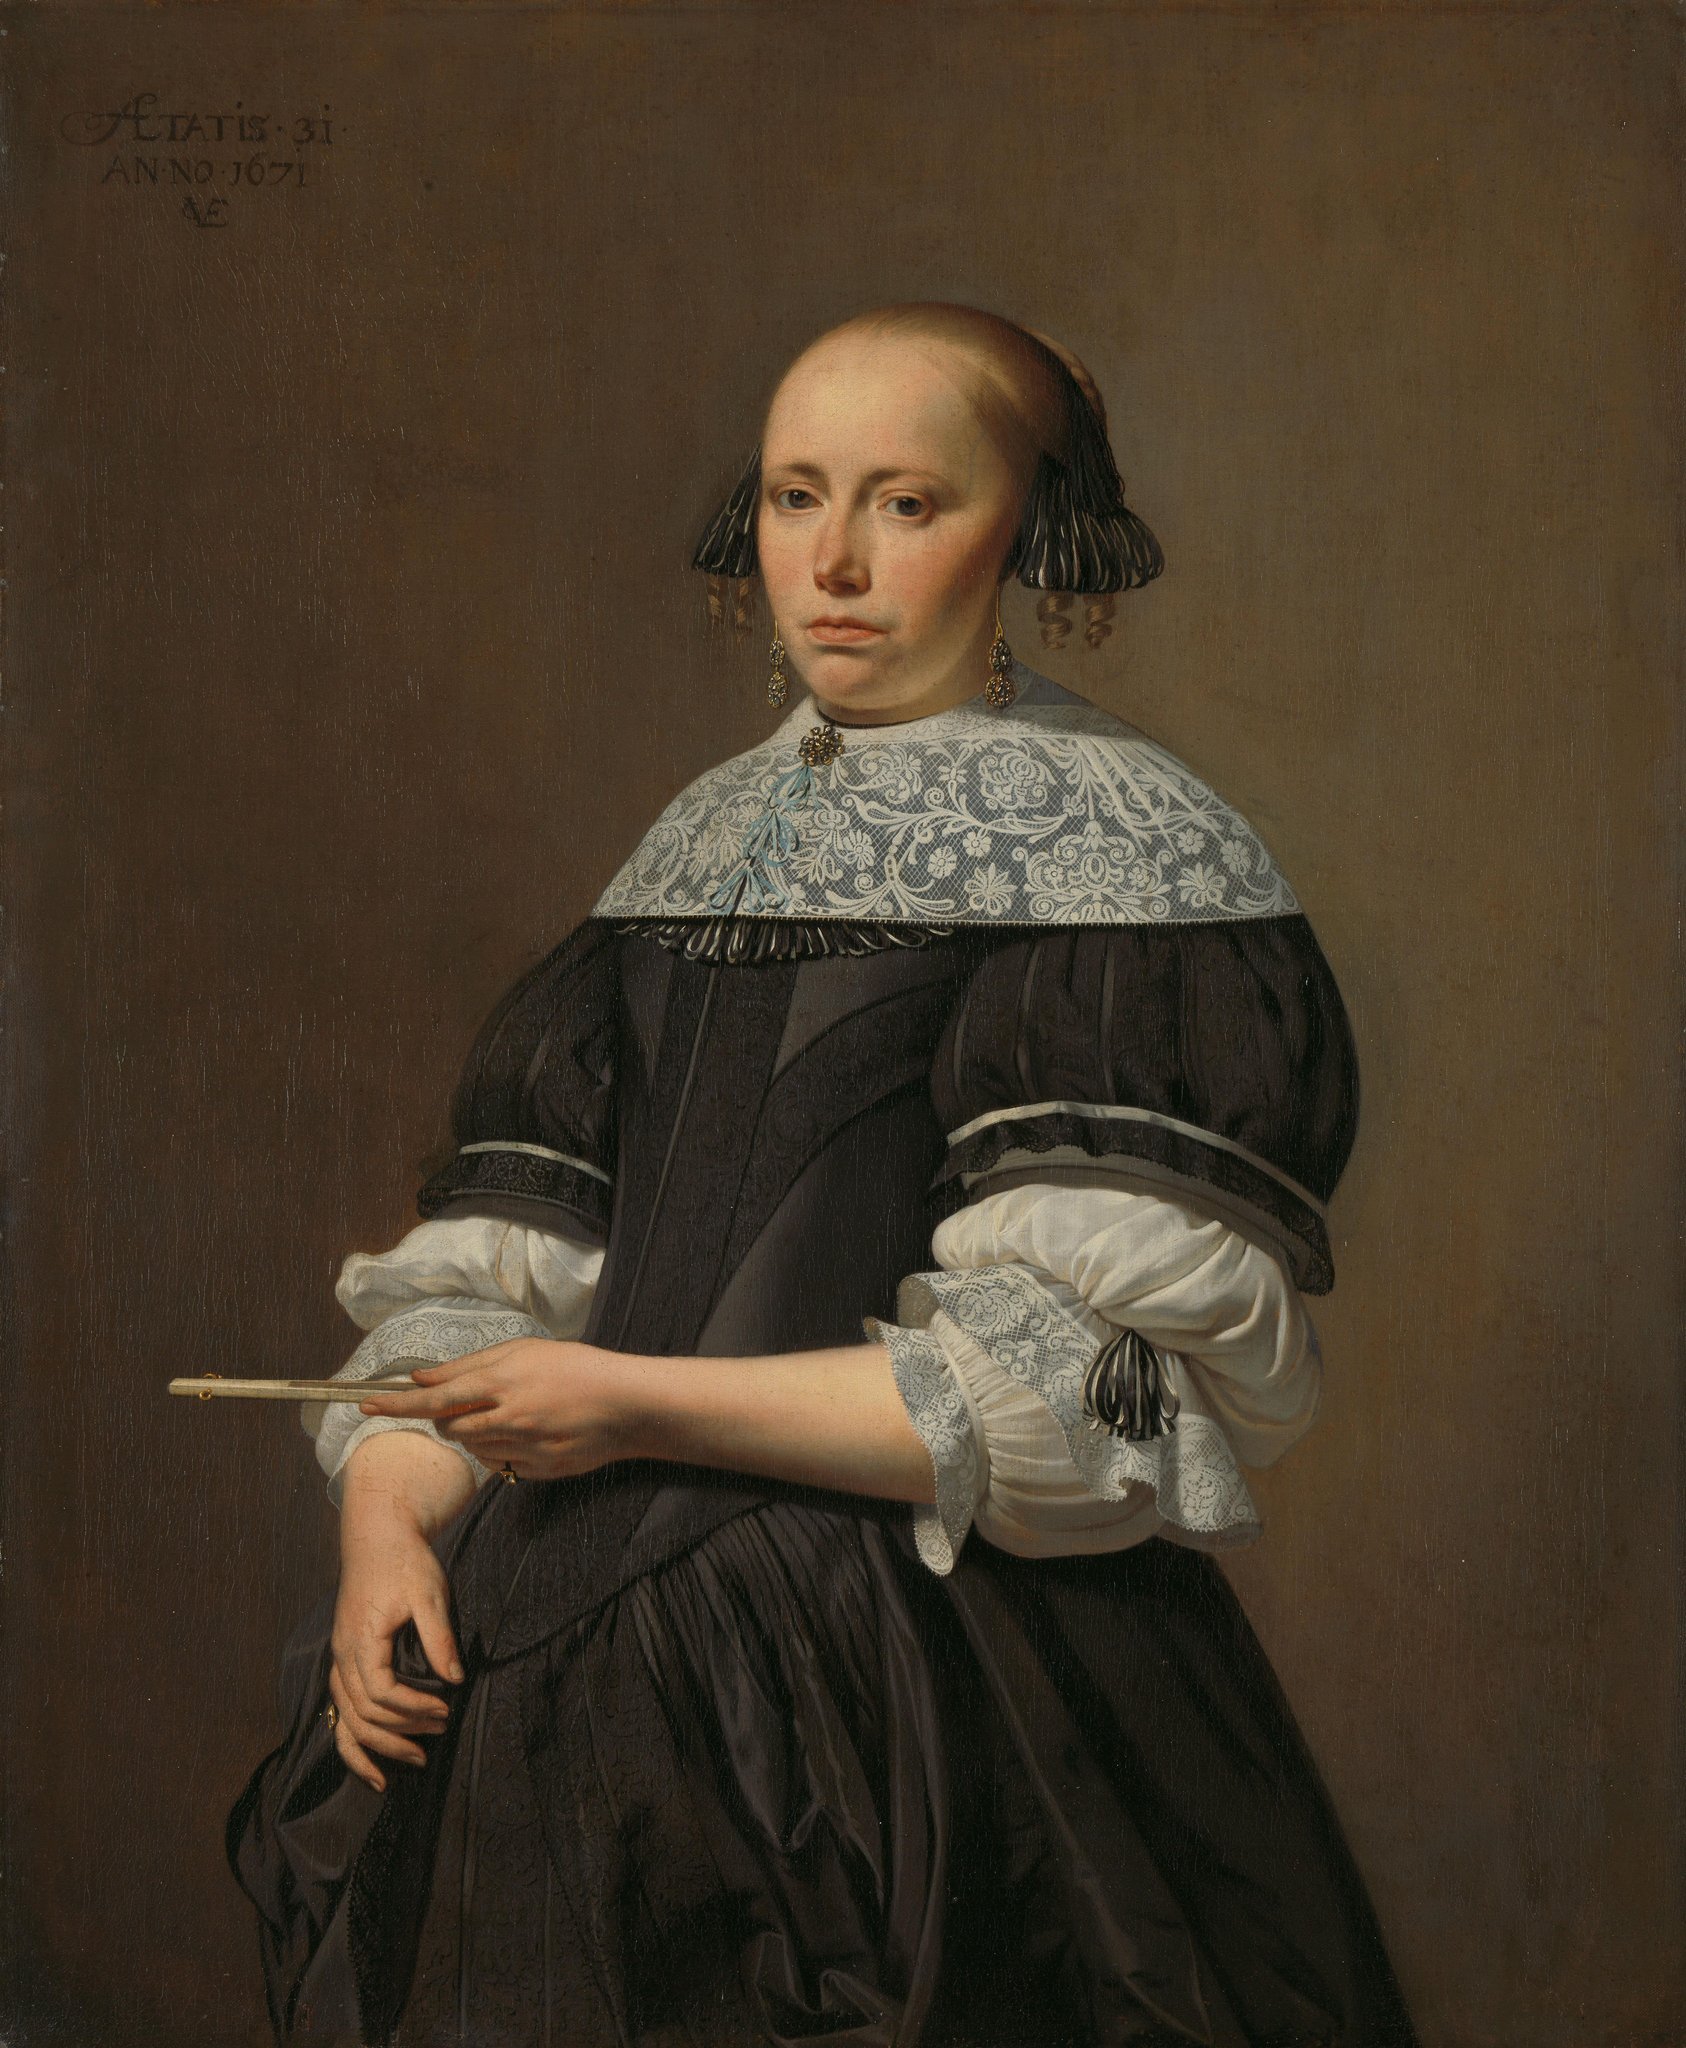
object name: painting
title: Portrait of Elisabeth Pietersdr Kessels (1640-1717)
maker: caesar van everdingen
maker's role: draughtsman, painter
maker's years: 1616-1678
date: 1671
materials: canvas, oil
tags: elisabeth van kessel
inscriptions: signature, date and inscription, with ligated monogram, upper left (A and E ligated): ‘AETATIS. 31. / AN.NO. 1671 / cVE’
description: Portret van Elisabeth van Kessel, echtgenote van Willem Jacobsz Baert. Ten halven lijve, naar links, een waaier in de linkerhand. Pendant van SK-A-1339.